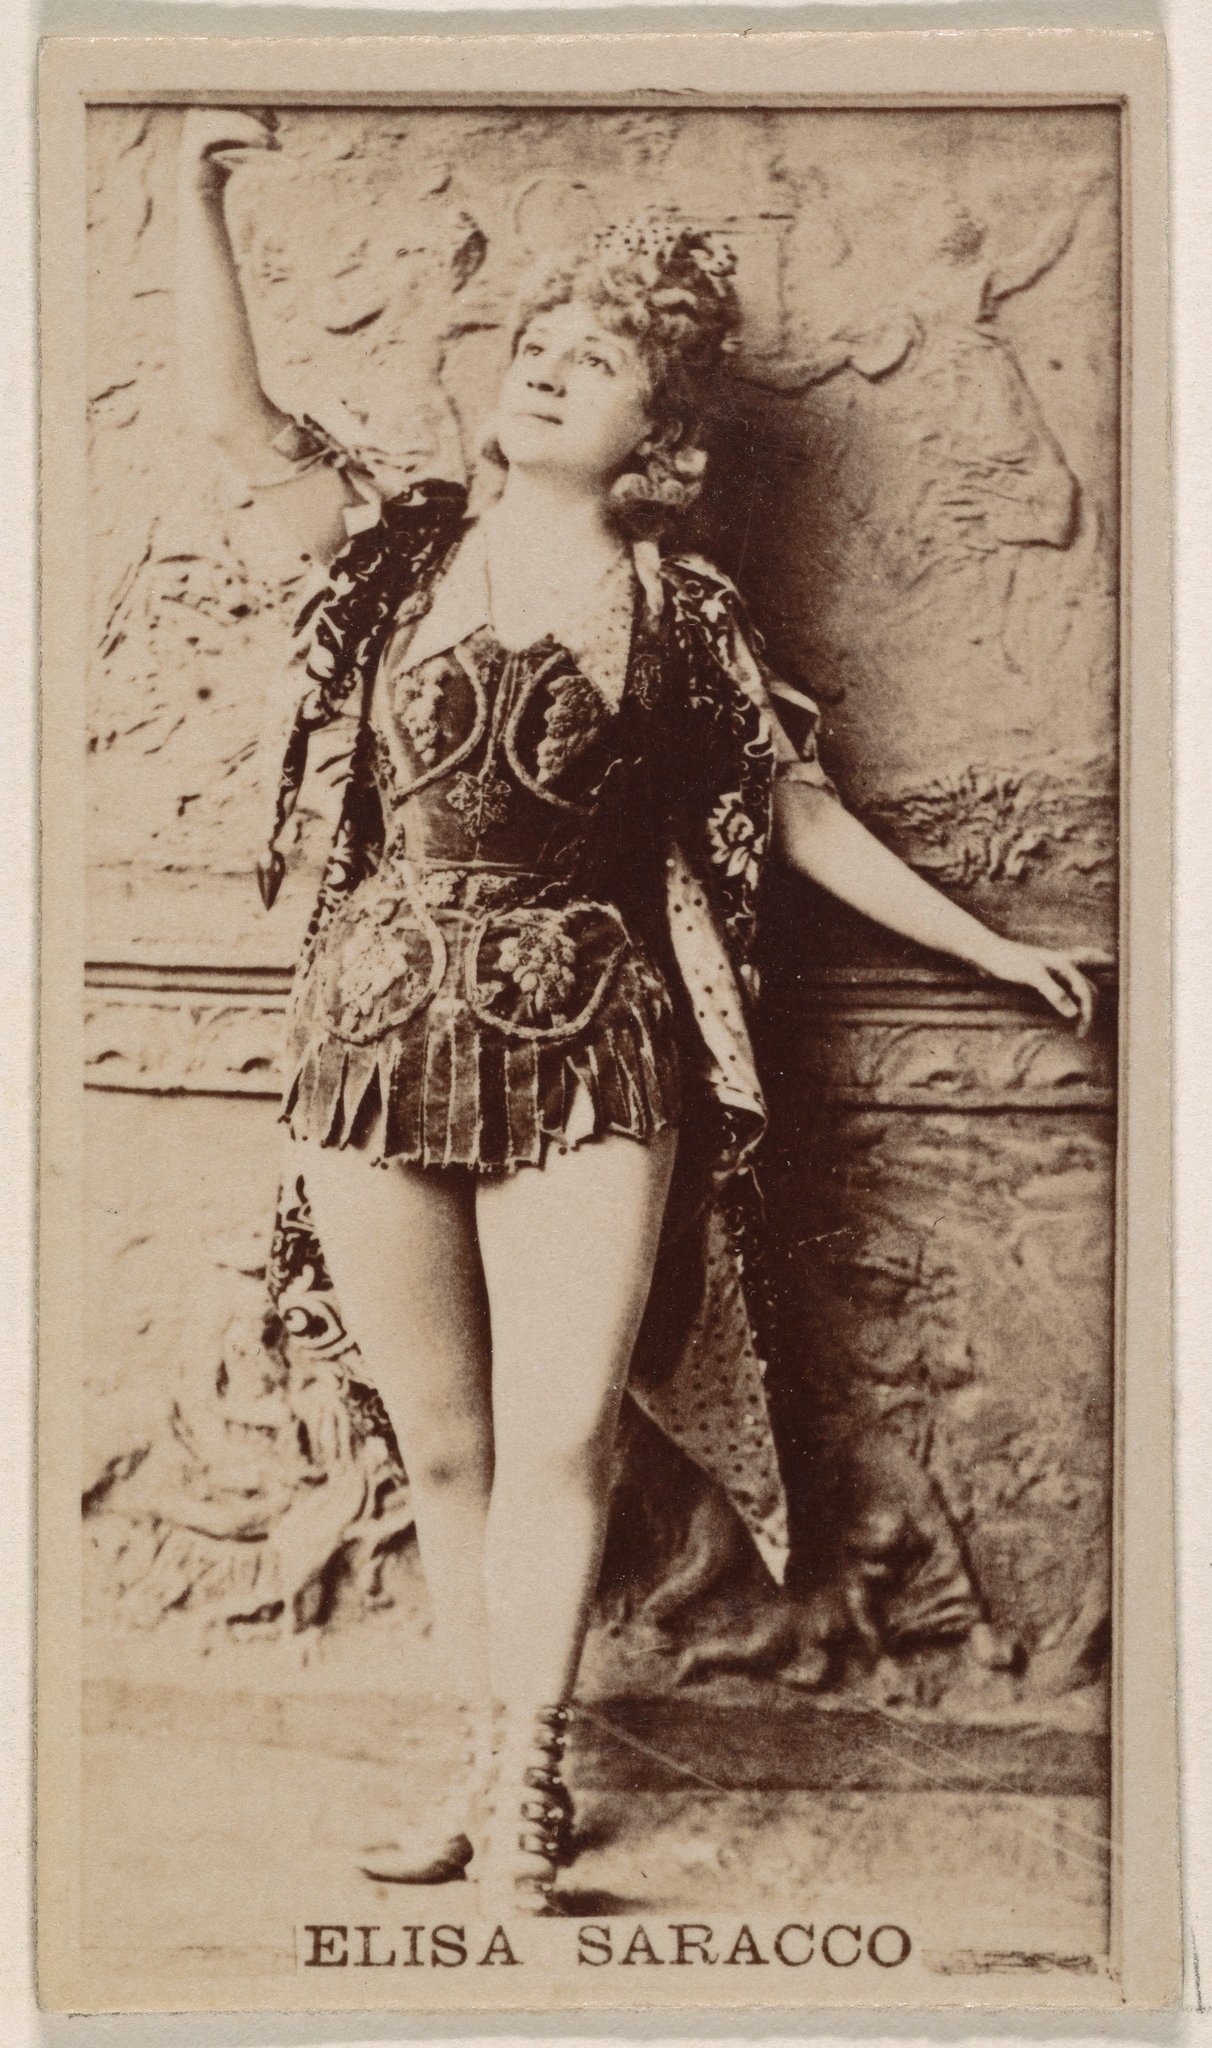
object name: photograph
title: Mlle. Elisa Saracco, from the Actresses series (N245) issued by Kinney Brothers to promote Sweet Caporal Cigarettes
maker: kinney brothers tobacco company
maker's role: publisher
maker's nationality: american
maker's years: 1869-2011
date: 1890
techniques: albumen silver print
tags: portraits,women,actresses